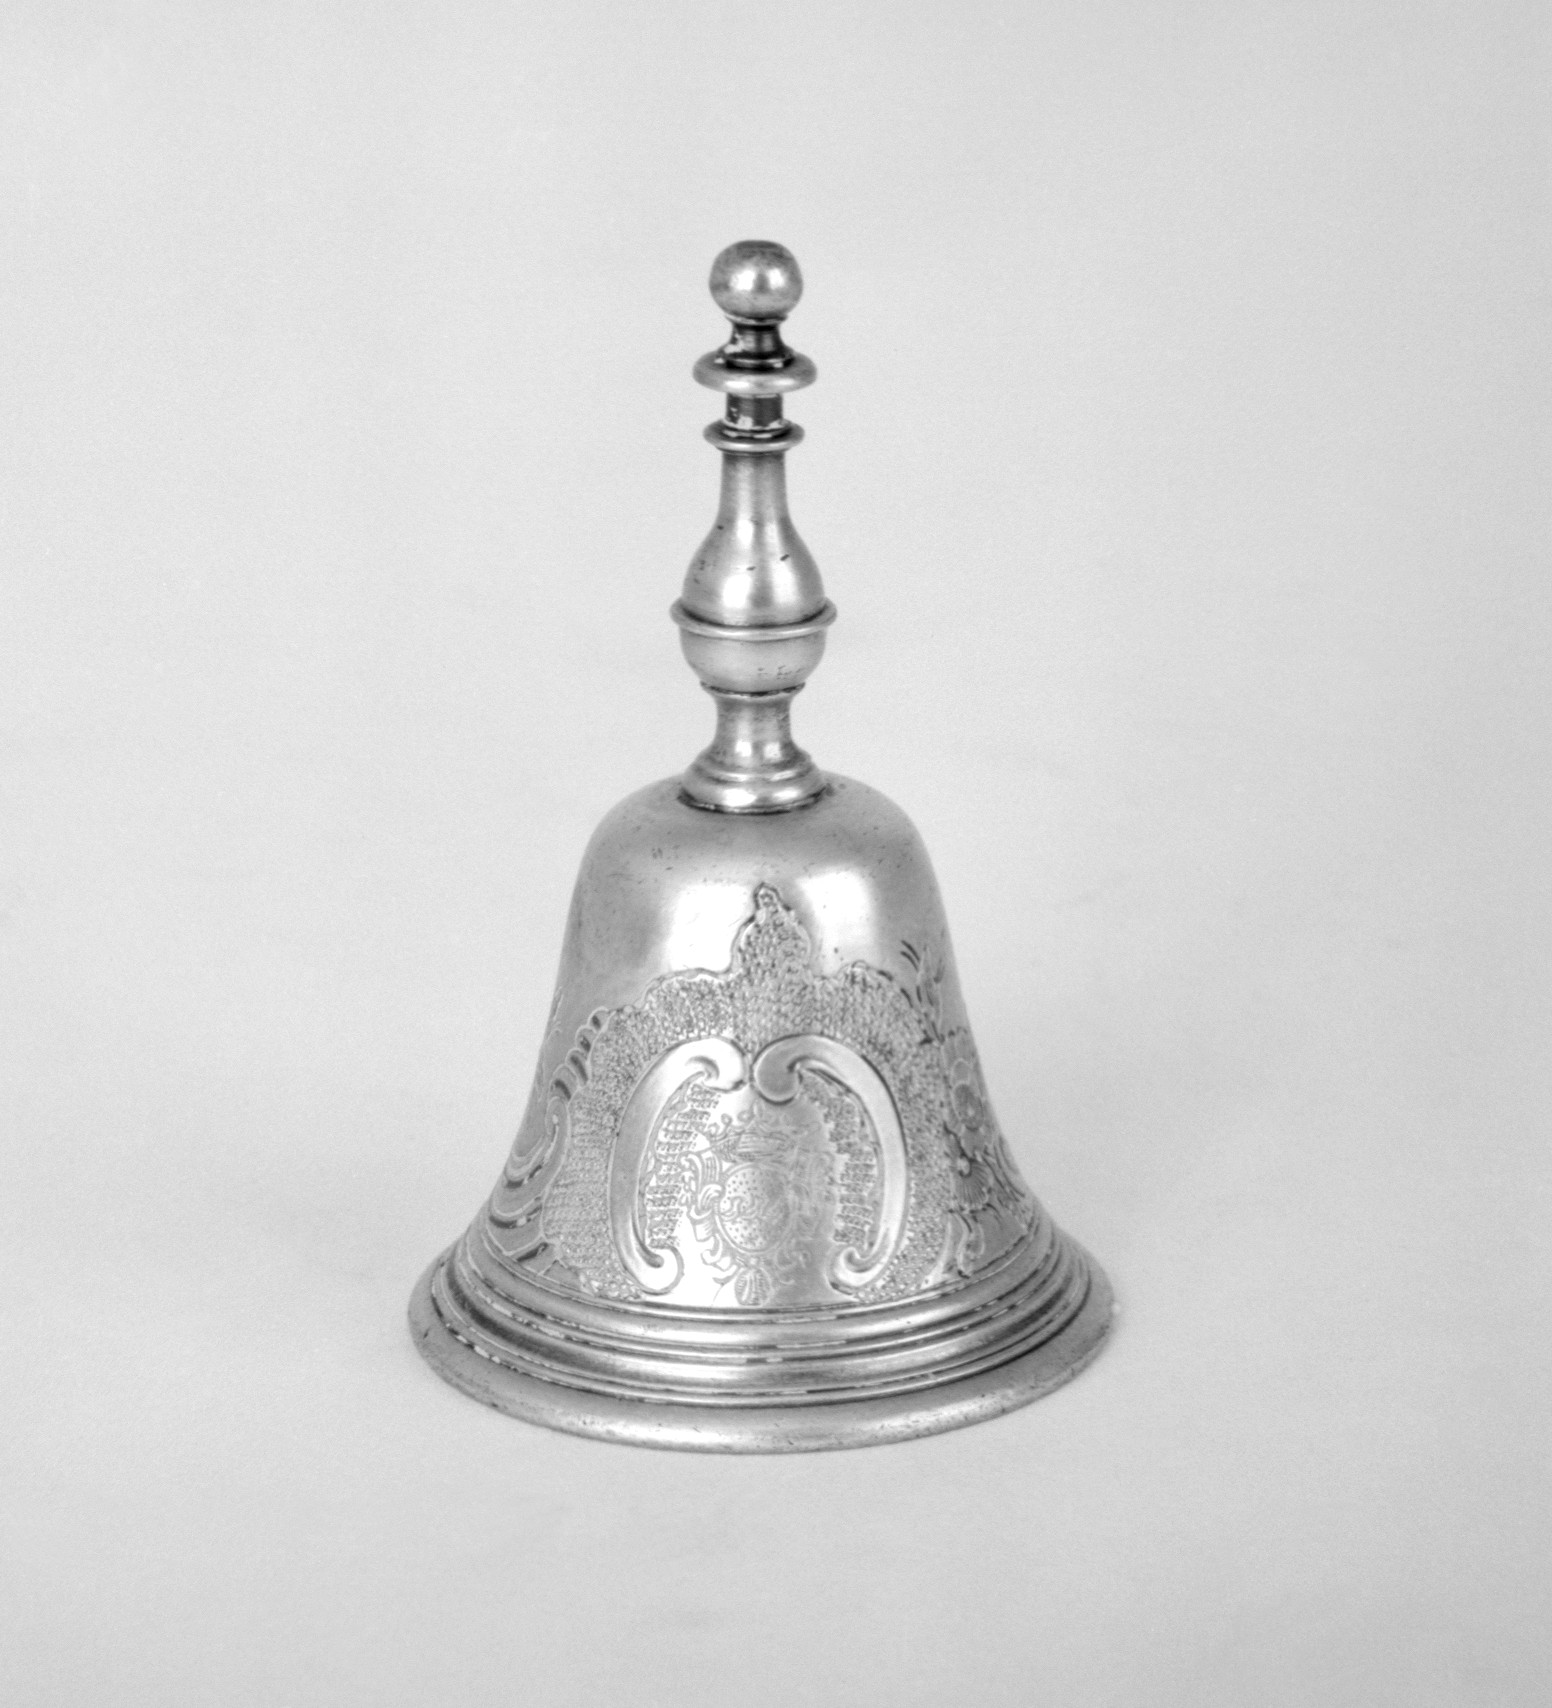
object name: table bell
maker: johann martin satzger i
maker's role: maker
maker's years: 1707-1785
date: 1755-1757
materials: silver gilt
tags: musical instruments,coat of arms